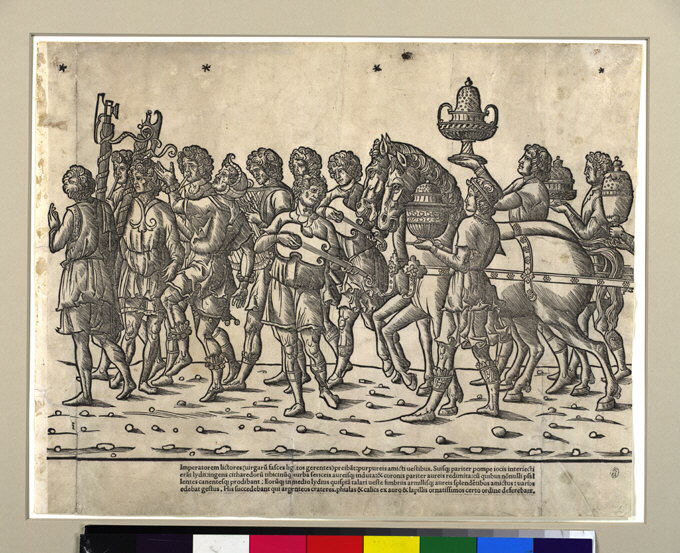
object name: print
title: Soldiers, musicians and horses, from "The Triumph of Caesar"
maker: jacob of strasbourg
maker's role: artist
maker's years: 1494-1530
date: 1504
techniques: woodcut